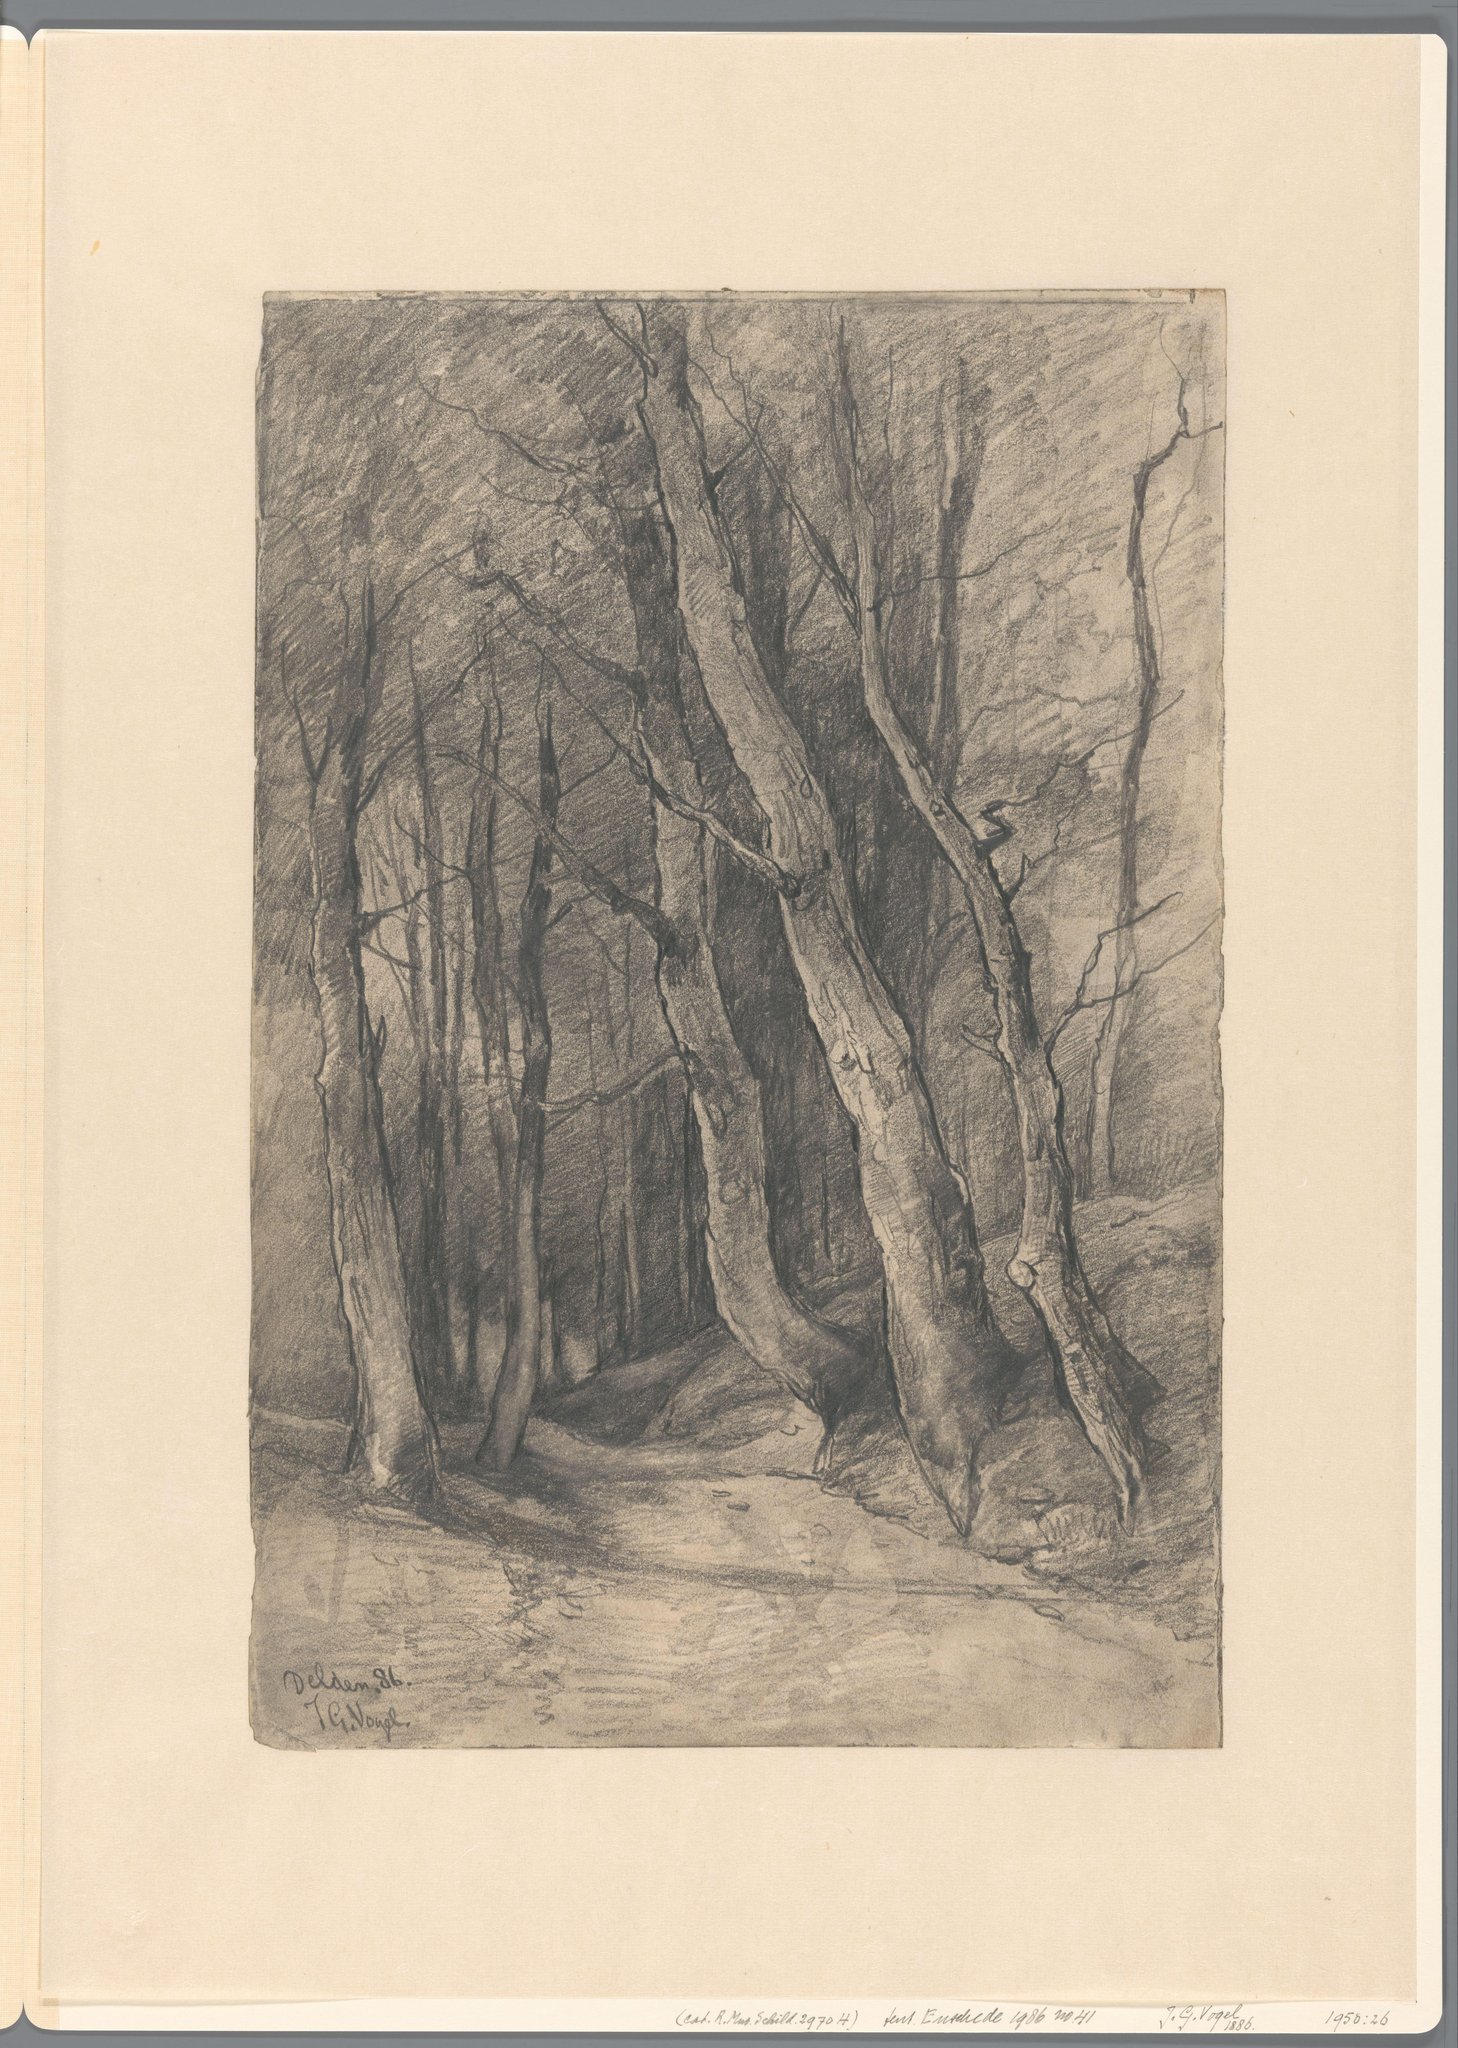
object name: drawing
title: Boslandschap bij Delden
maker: johannes gijsbert vogel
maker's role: draughtsman, painter, print maker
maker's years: 1828-1915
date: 1886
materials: paper, pencil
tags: forest, wood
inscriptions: collector's mark: Lugt 2228